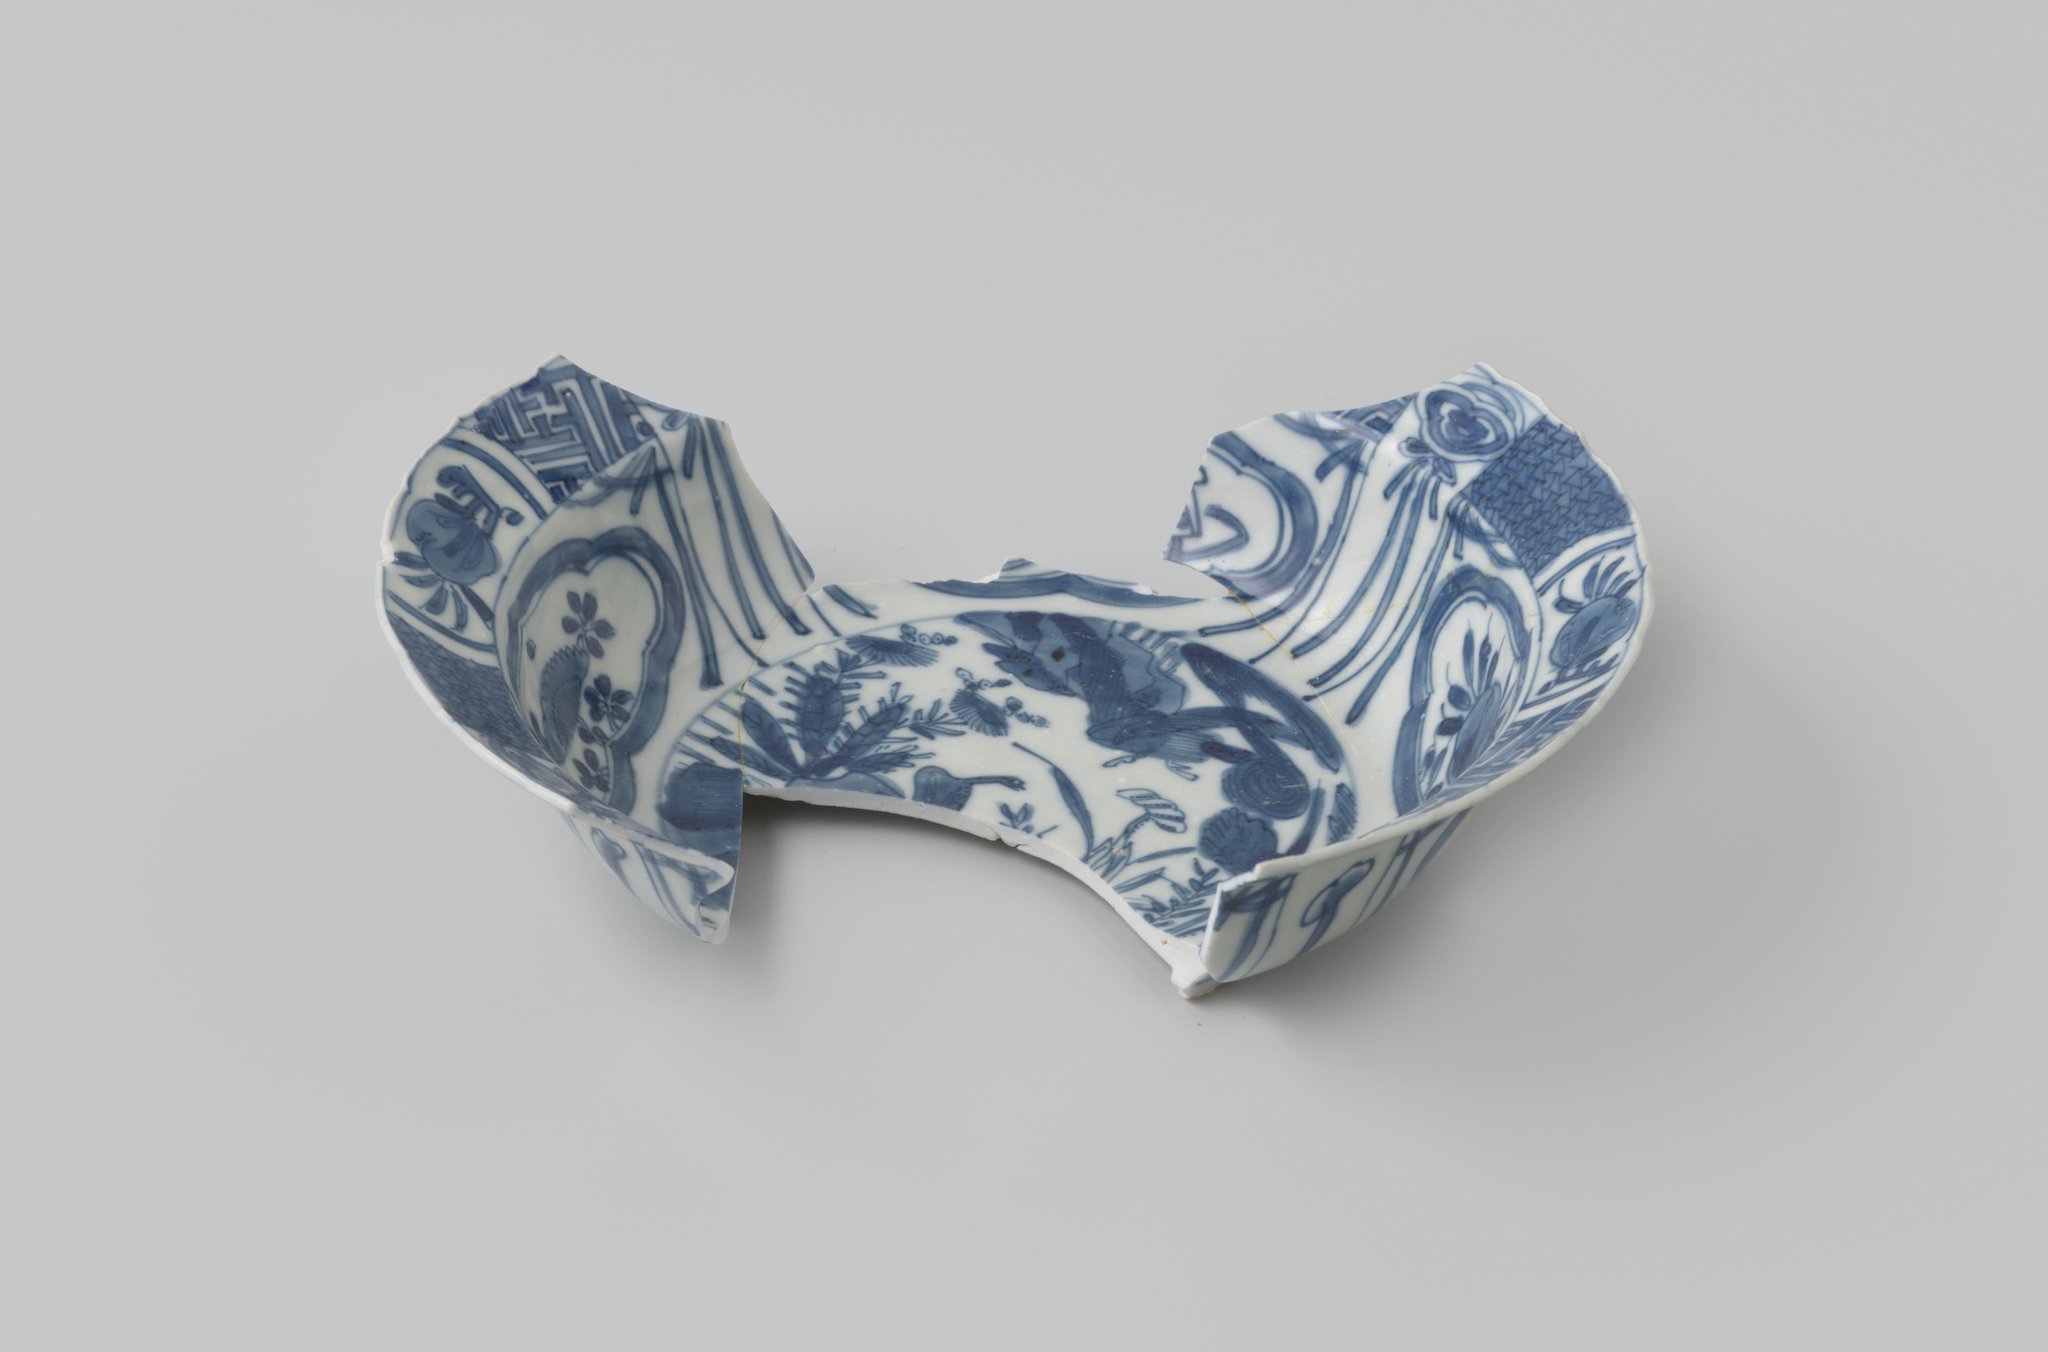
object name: deep dish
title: Diep bord uit V.O.C.-schip de 'Witte Leeuw'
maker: Anonymous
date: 1613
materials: bone china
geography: jingdezhen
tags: verenigde oostindische compagnie, sint-helena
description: A bowl with a flattened rim. Cartouches with fruits enclosed by diaper patterns. A central decoration of birds and a lotus. Panels decorated with peaches and symbols.